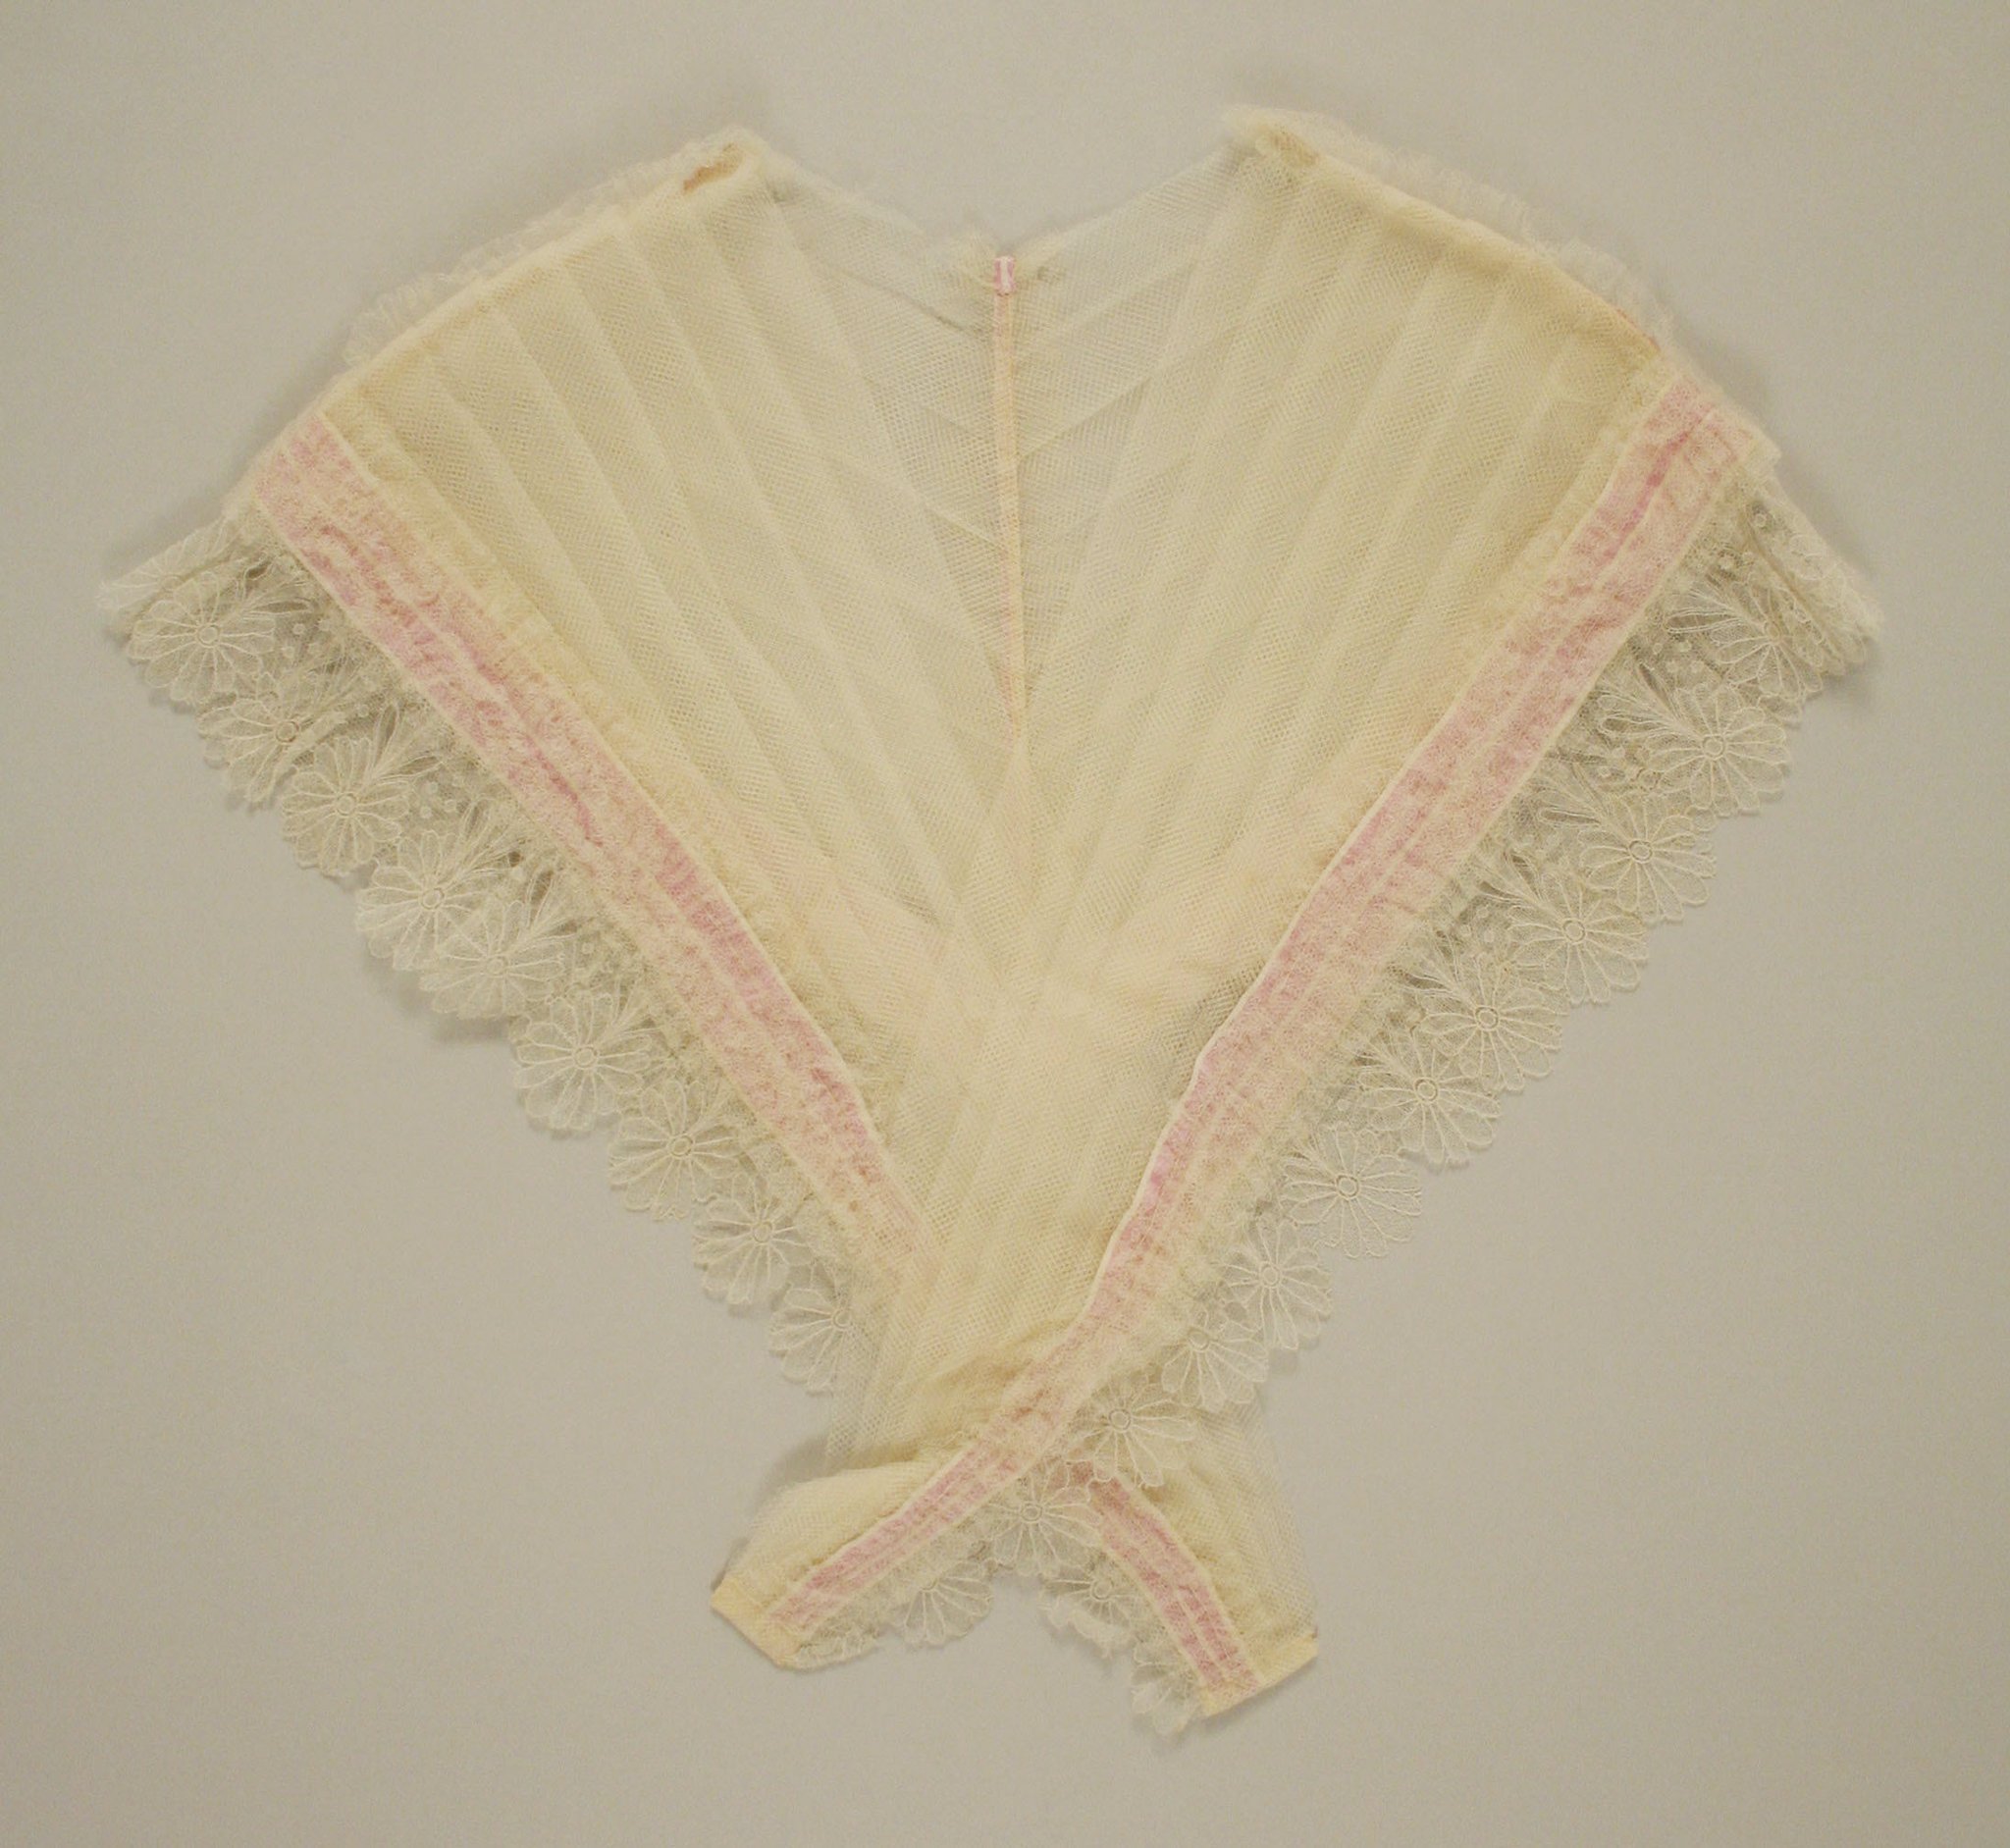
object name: fichu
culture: american or european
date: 1834-1866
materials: silk